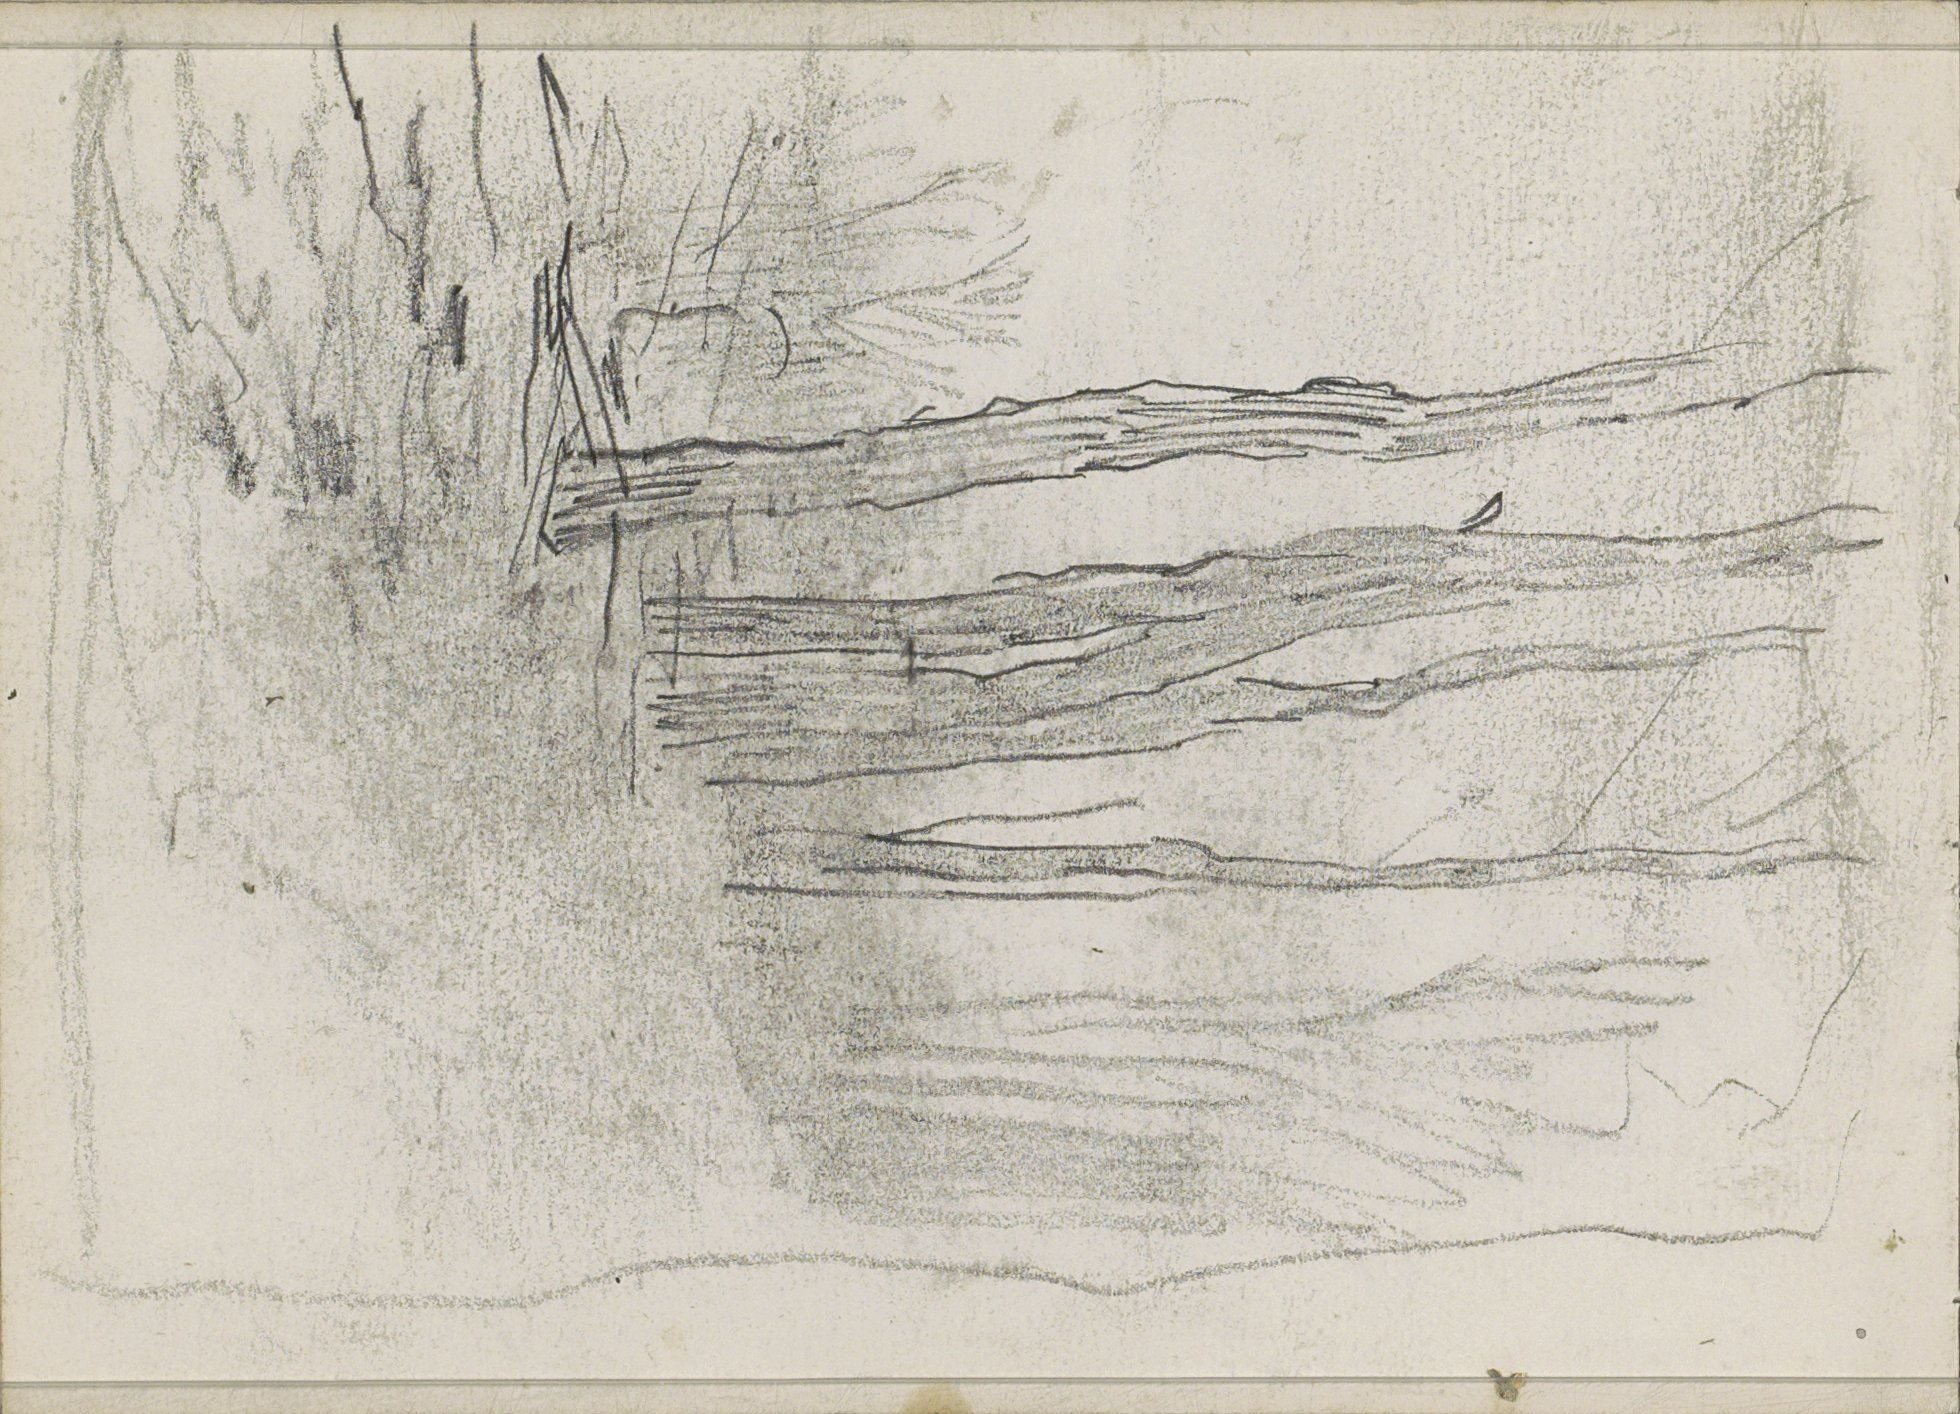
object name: sketchbook leaf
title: Rij boomstammen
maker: anton mauve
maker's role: draughtsman, painter, print maker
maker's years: 1838-1888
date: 1848-1888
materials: paper, pencil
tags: trees (+ stem, trunk)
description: Blad 6 verso uit een schetsboek met 31 bladen.